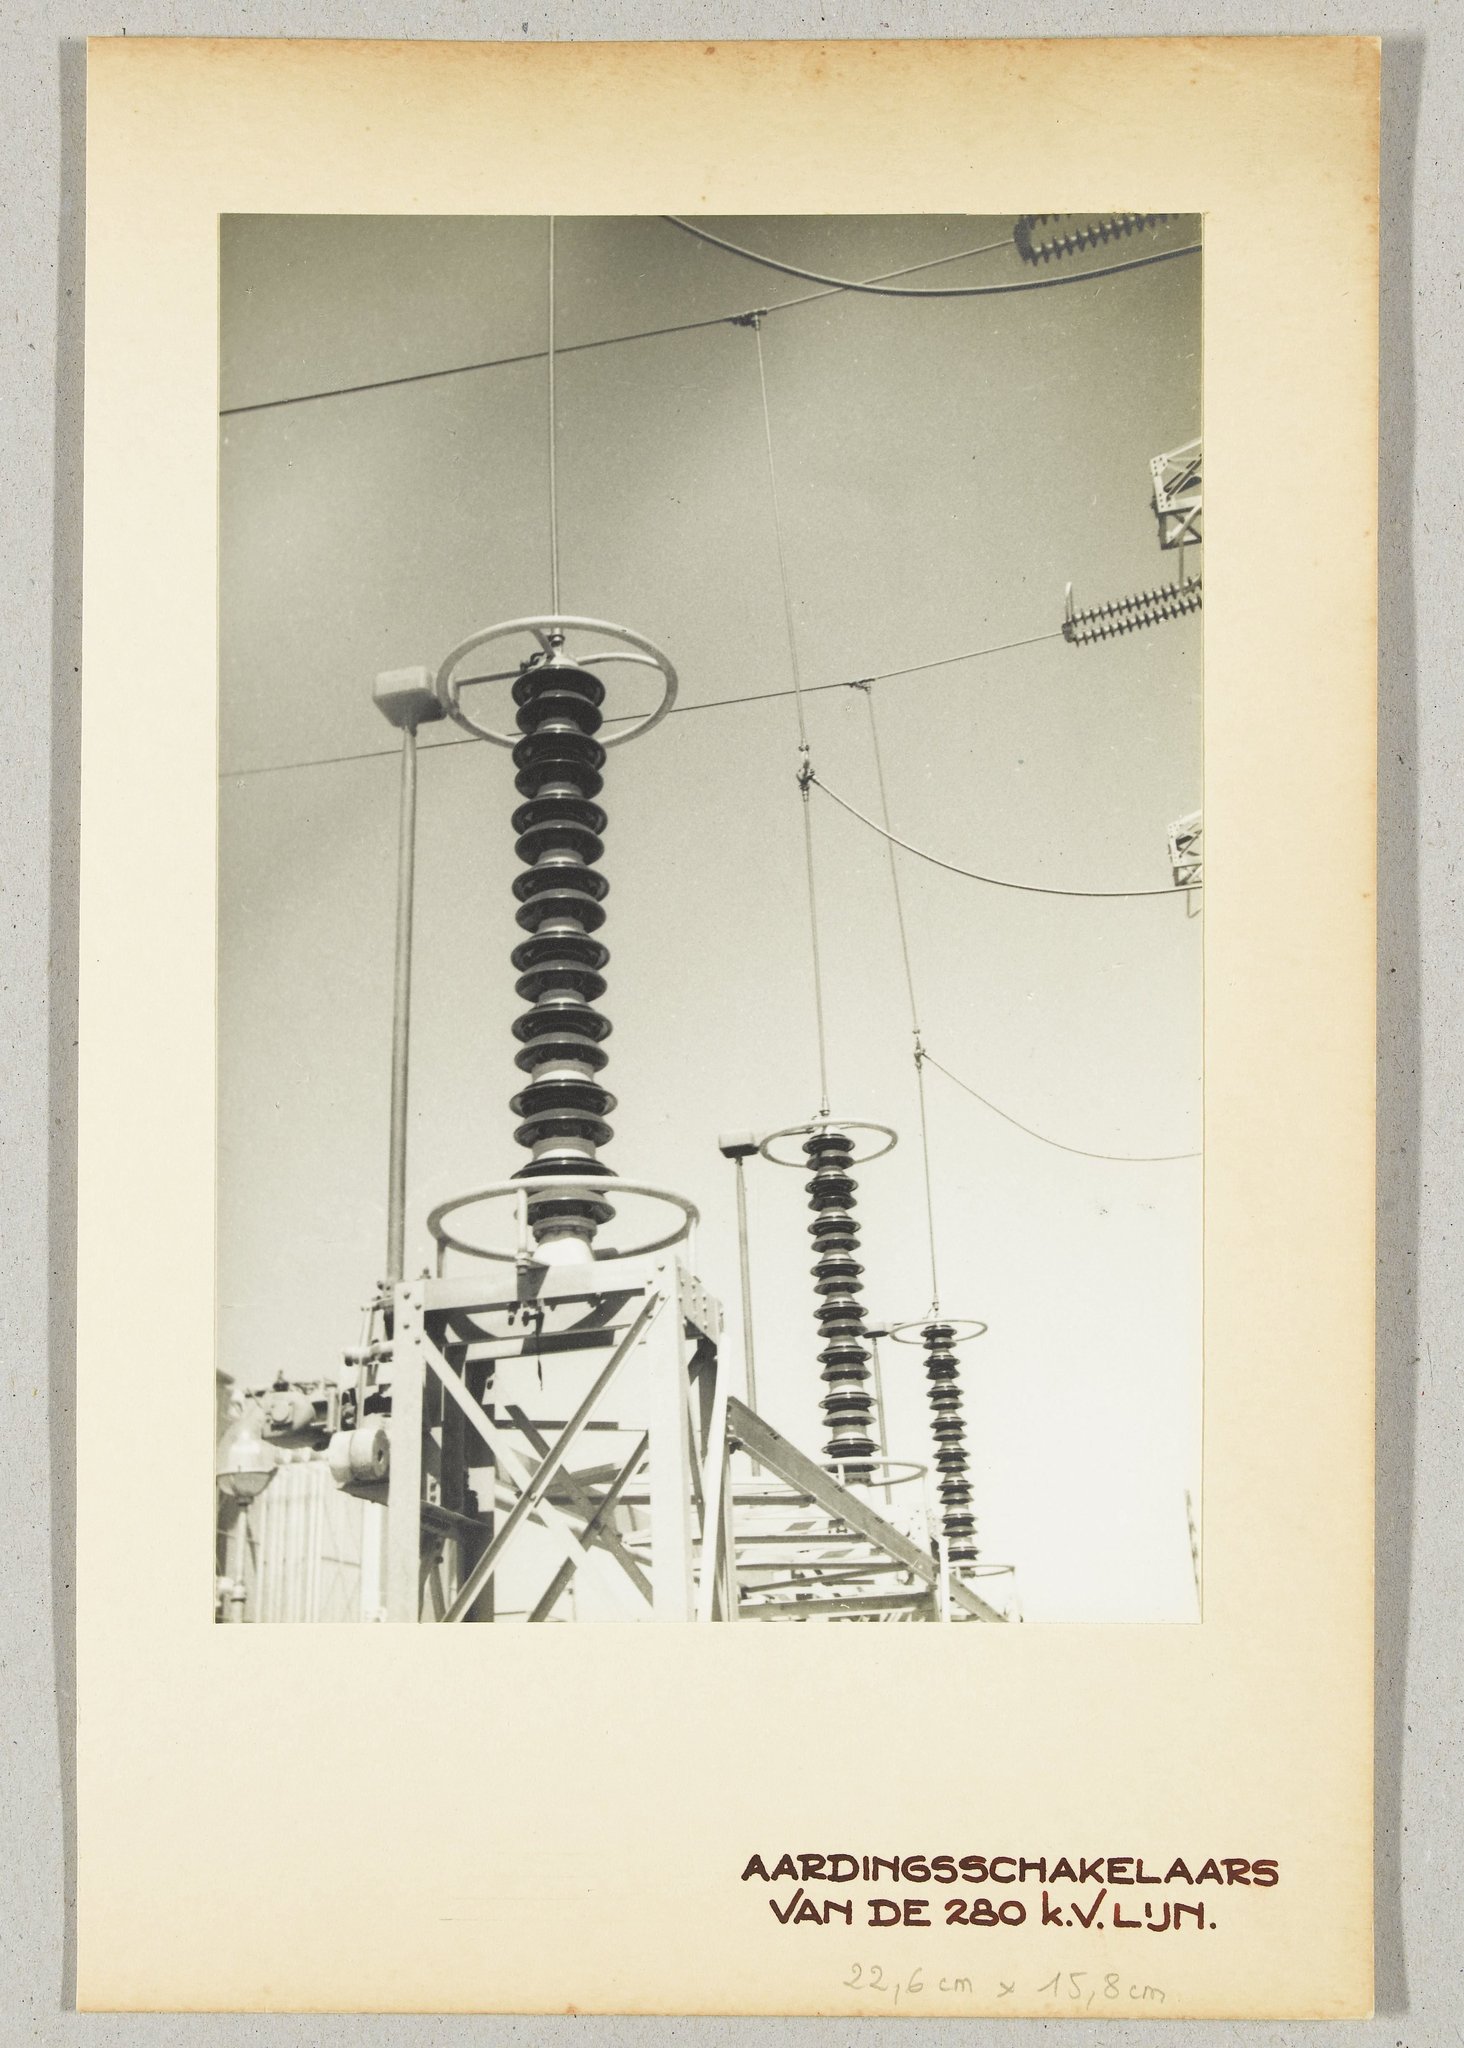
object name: photograph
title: Aardingsschakelaars in electra lijnen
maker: wouter cool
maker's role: engineer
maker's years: 1877-1947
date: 1936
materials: cardboard, paper, photographic support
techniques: gelatin silver print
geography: united states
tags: power station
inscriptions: title: ‘AARDINGSSCHASKELAARS / VAN DE 280 k.V. LIJN.’